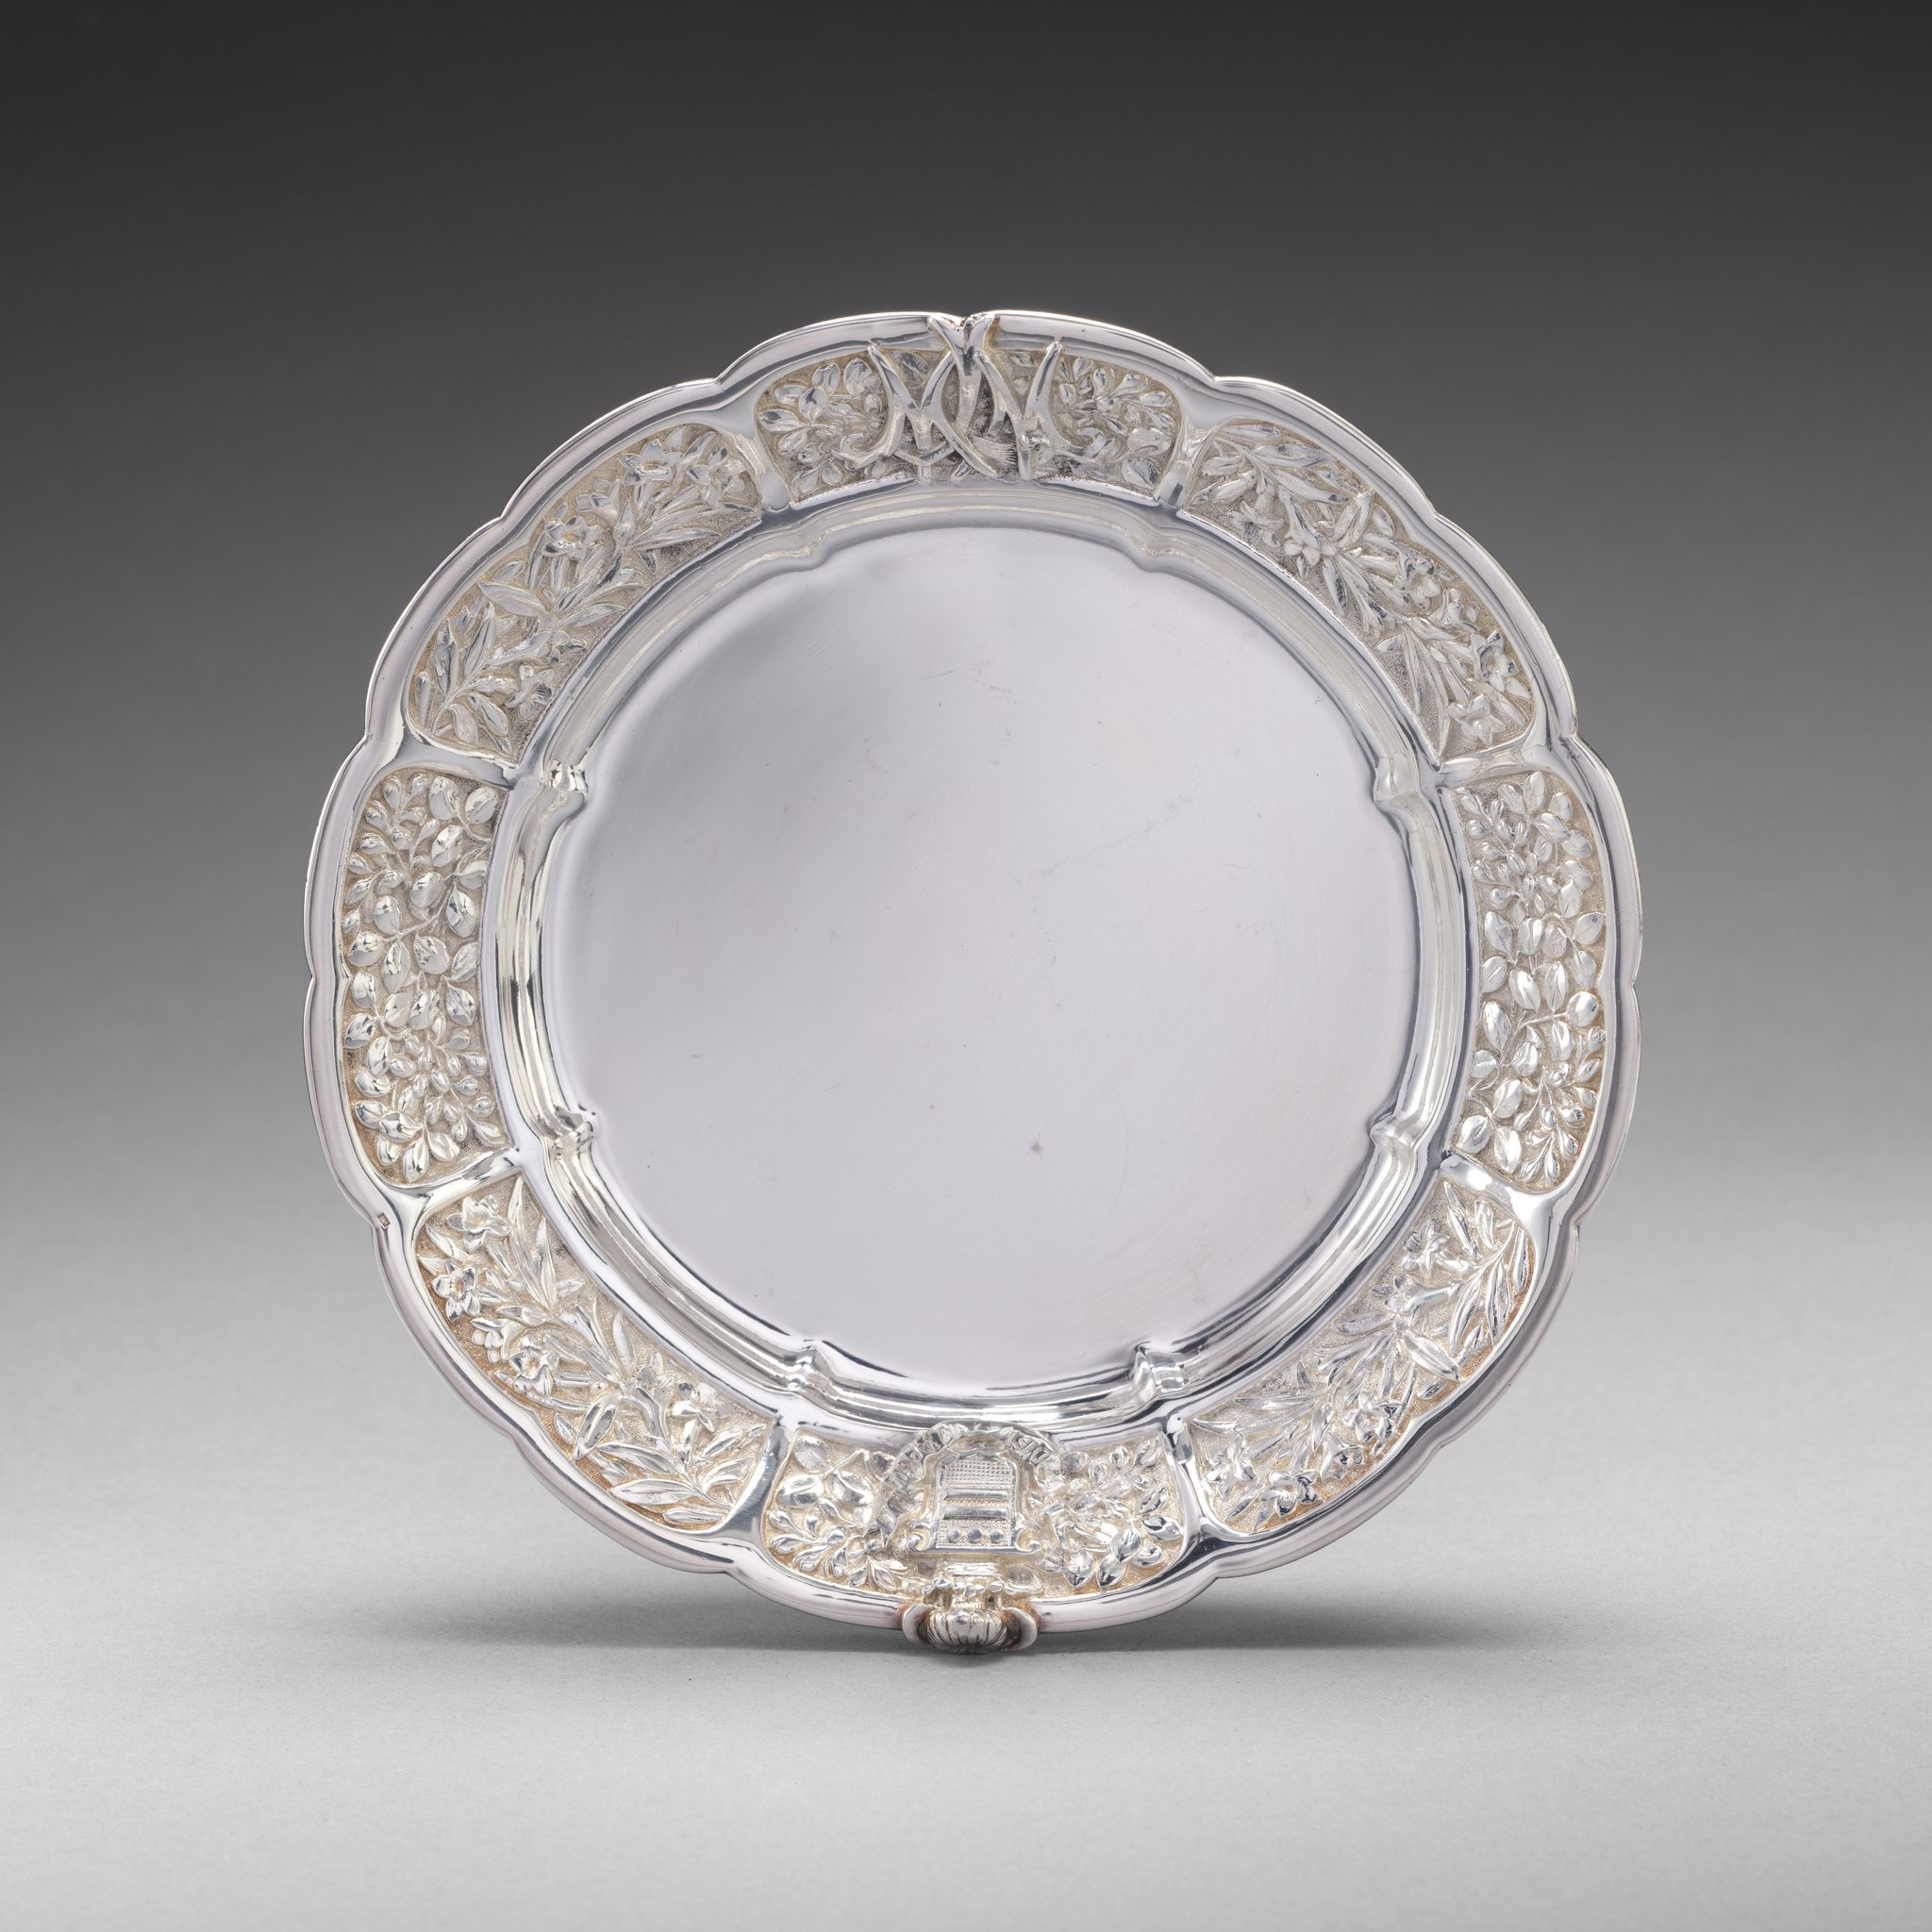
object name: ice cream plate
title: Ice Cream Plate from Mackay Service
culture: american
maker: tiffany & co.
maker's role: maker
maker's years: 1837-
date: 1878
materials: silver